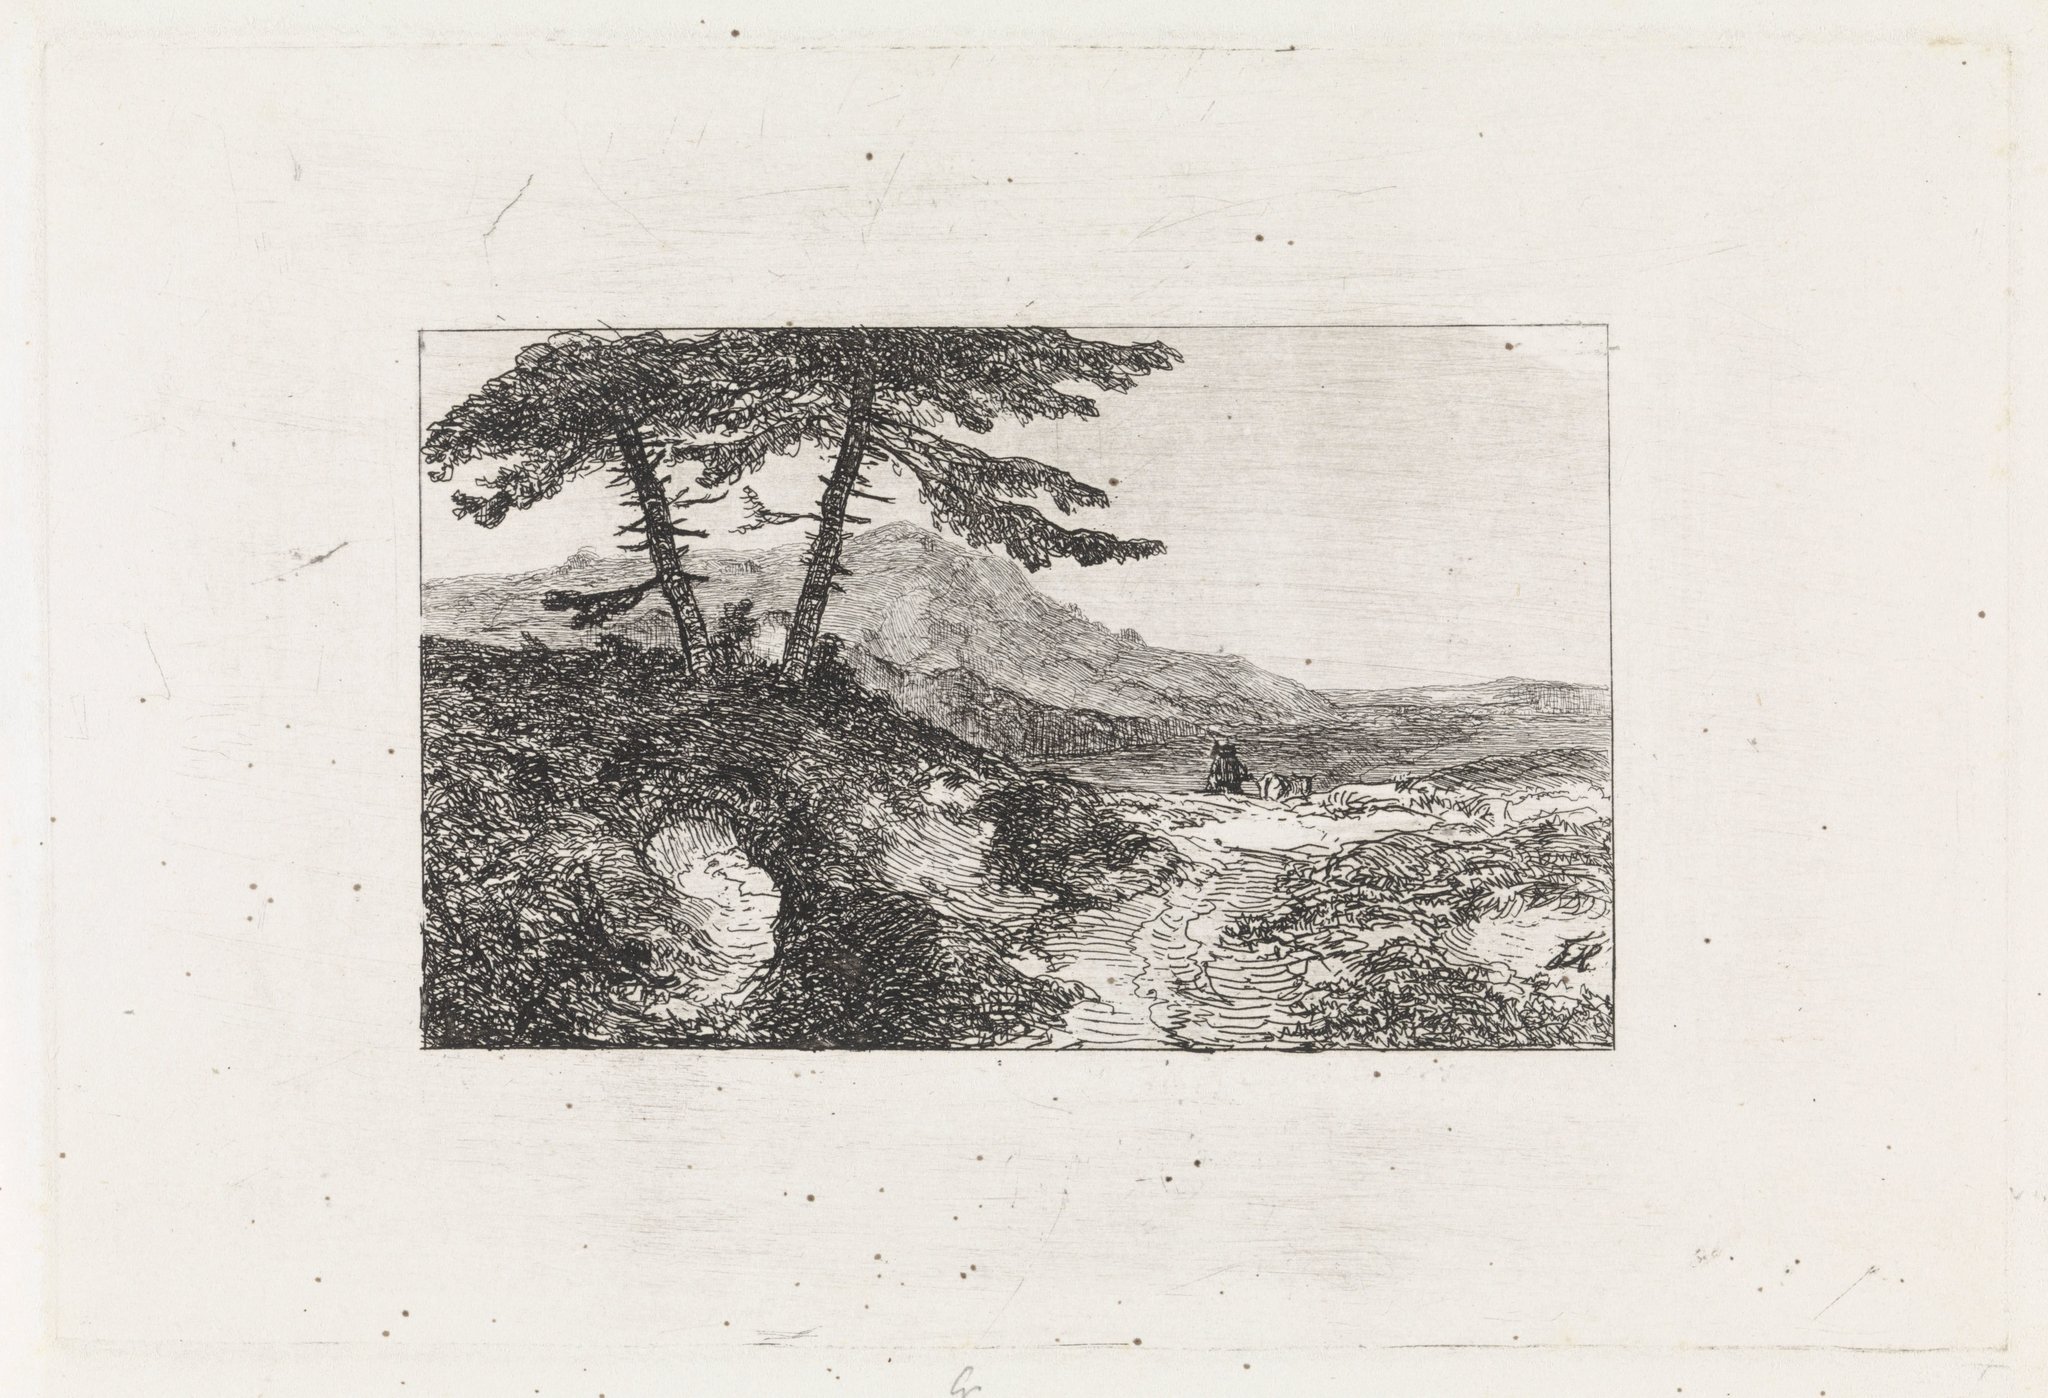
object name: print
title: Landschap met twee dennen op een heuvel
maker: johannes franciscus hoppenbrouwers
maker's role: draughtsman, painter, print maker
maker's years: 1819-1866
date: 1829-1866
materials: paper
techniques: etching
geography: the hague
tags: herding, herdsman, herdswoman, shepherd, shepherdess, cowherd, etc., dunes (sea not visible); in the dunes, groups of trees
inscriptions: collector's mark: Lugt 2228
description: Duinlandschap met links op de voorgrond twee dennen op een heuvel. In in het midden een figuur met een koe op een pad.